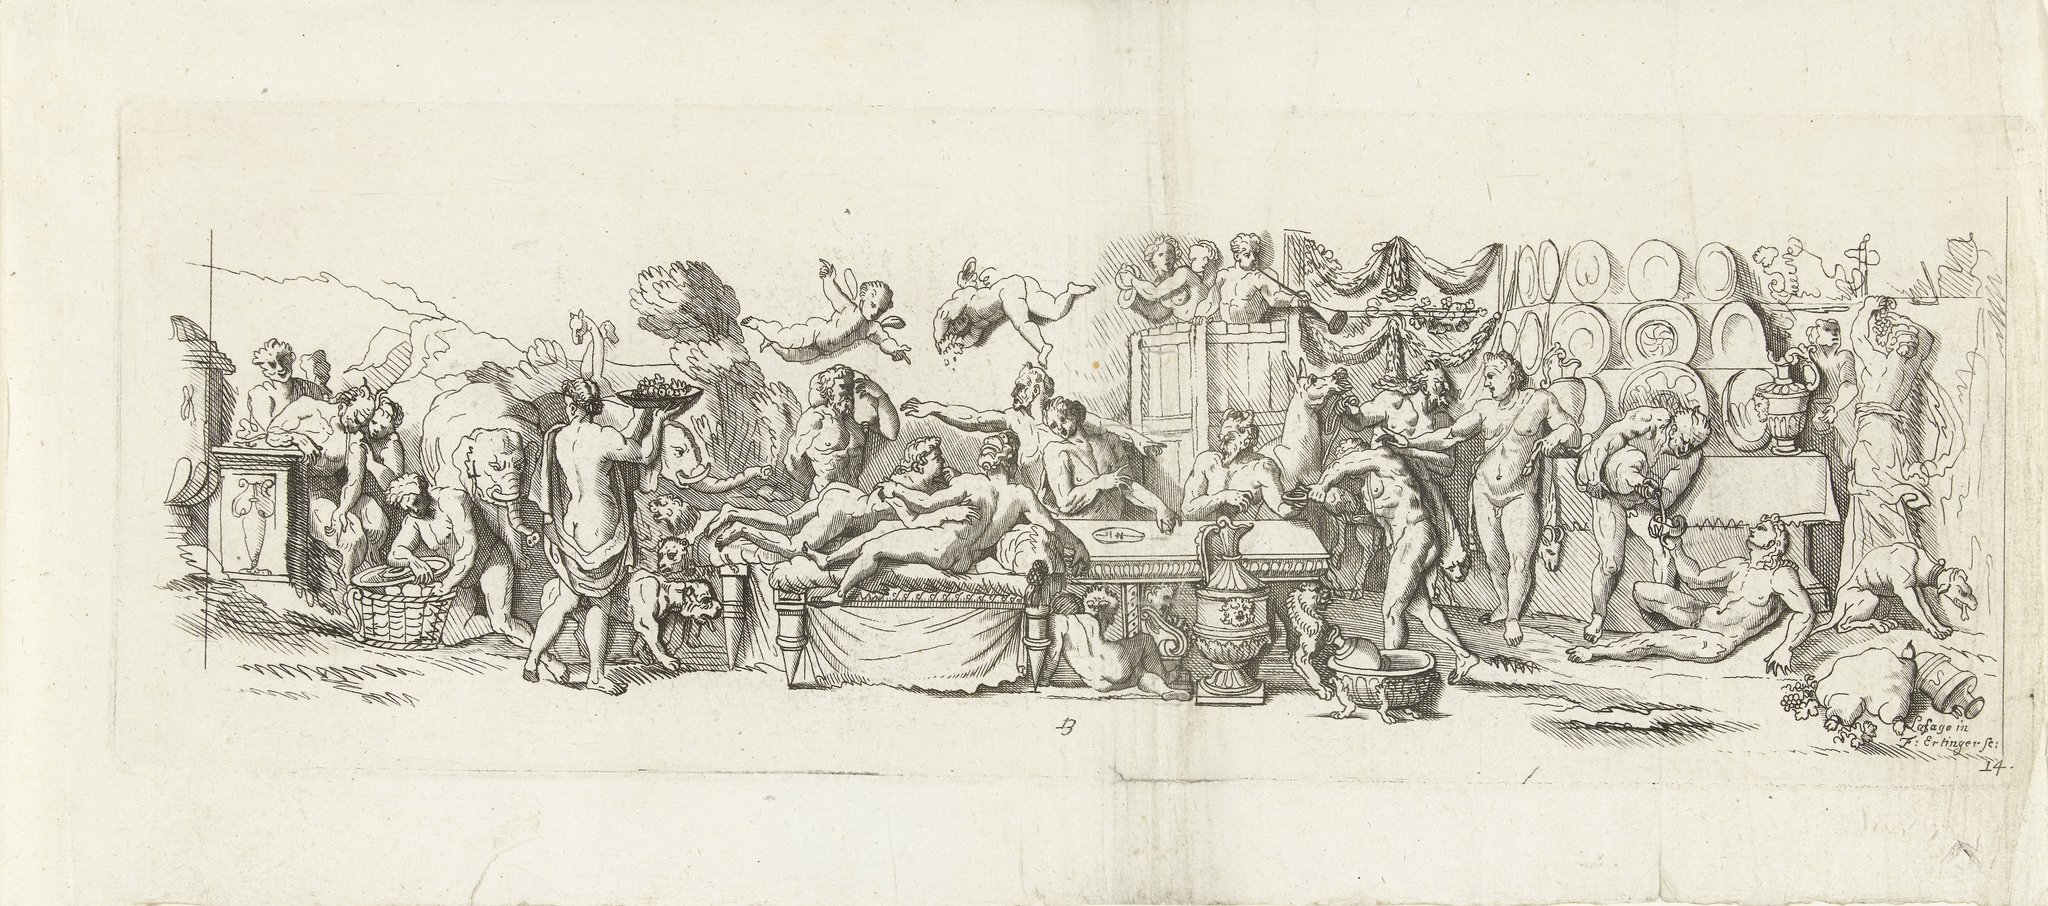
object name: print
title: Bacchanaal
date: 1652-1707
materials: paper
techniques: engraving, etching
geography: paris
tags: veneration of bacchus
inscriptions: collector's mark: Lugt 2760, collector's mark: Lugt 2228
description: Bacchanaal met naakte mannen, halfnaakte vrouwen en satyrs. Boven een tafel en een sofa met een naakt stel vliegen twee putti. Tussendoor lopen honden, olifanten en leeuwen.